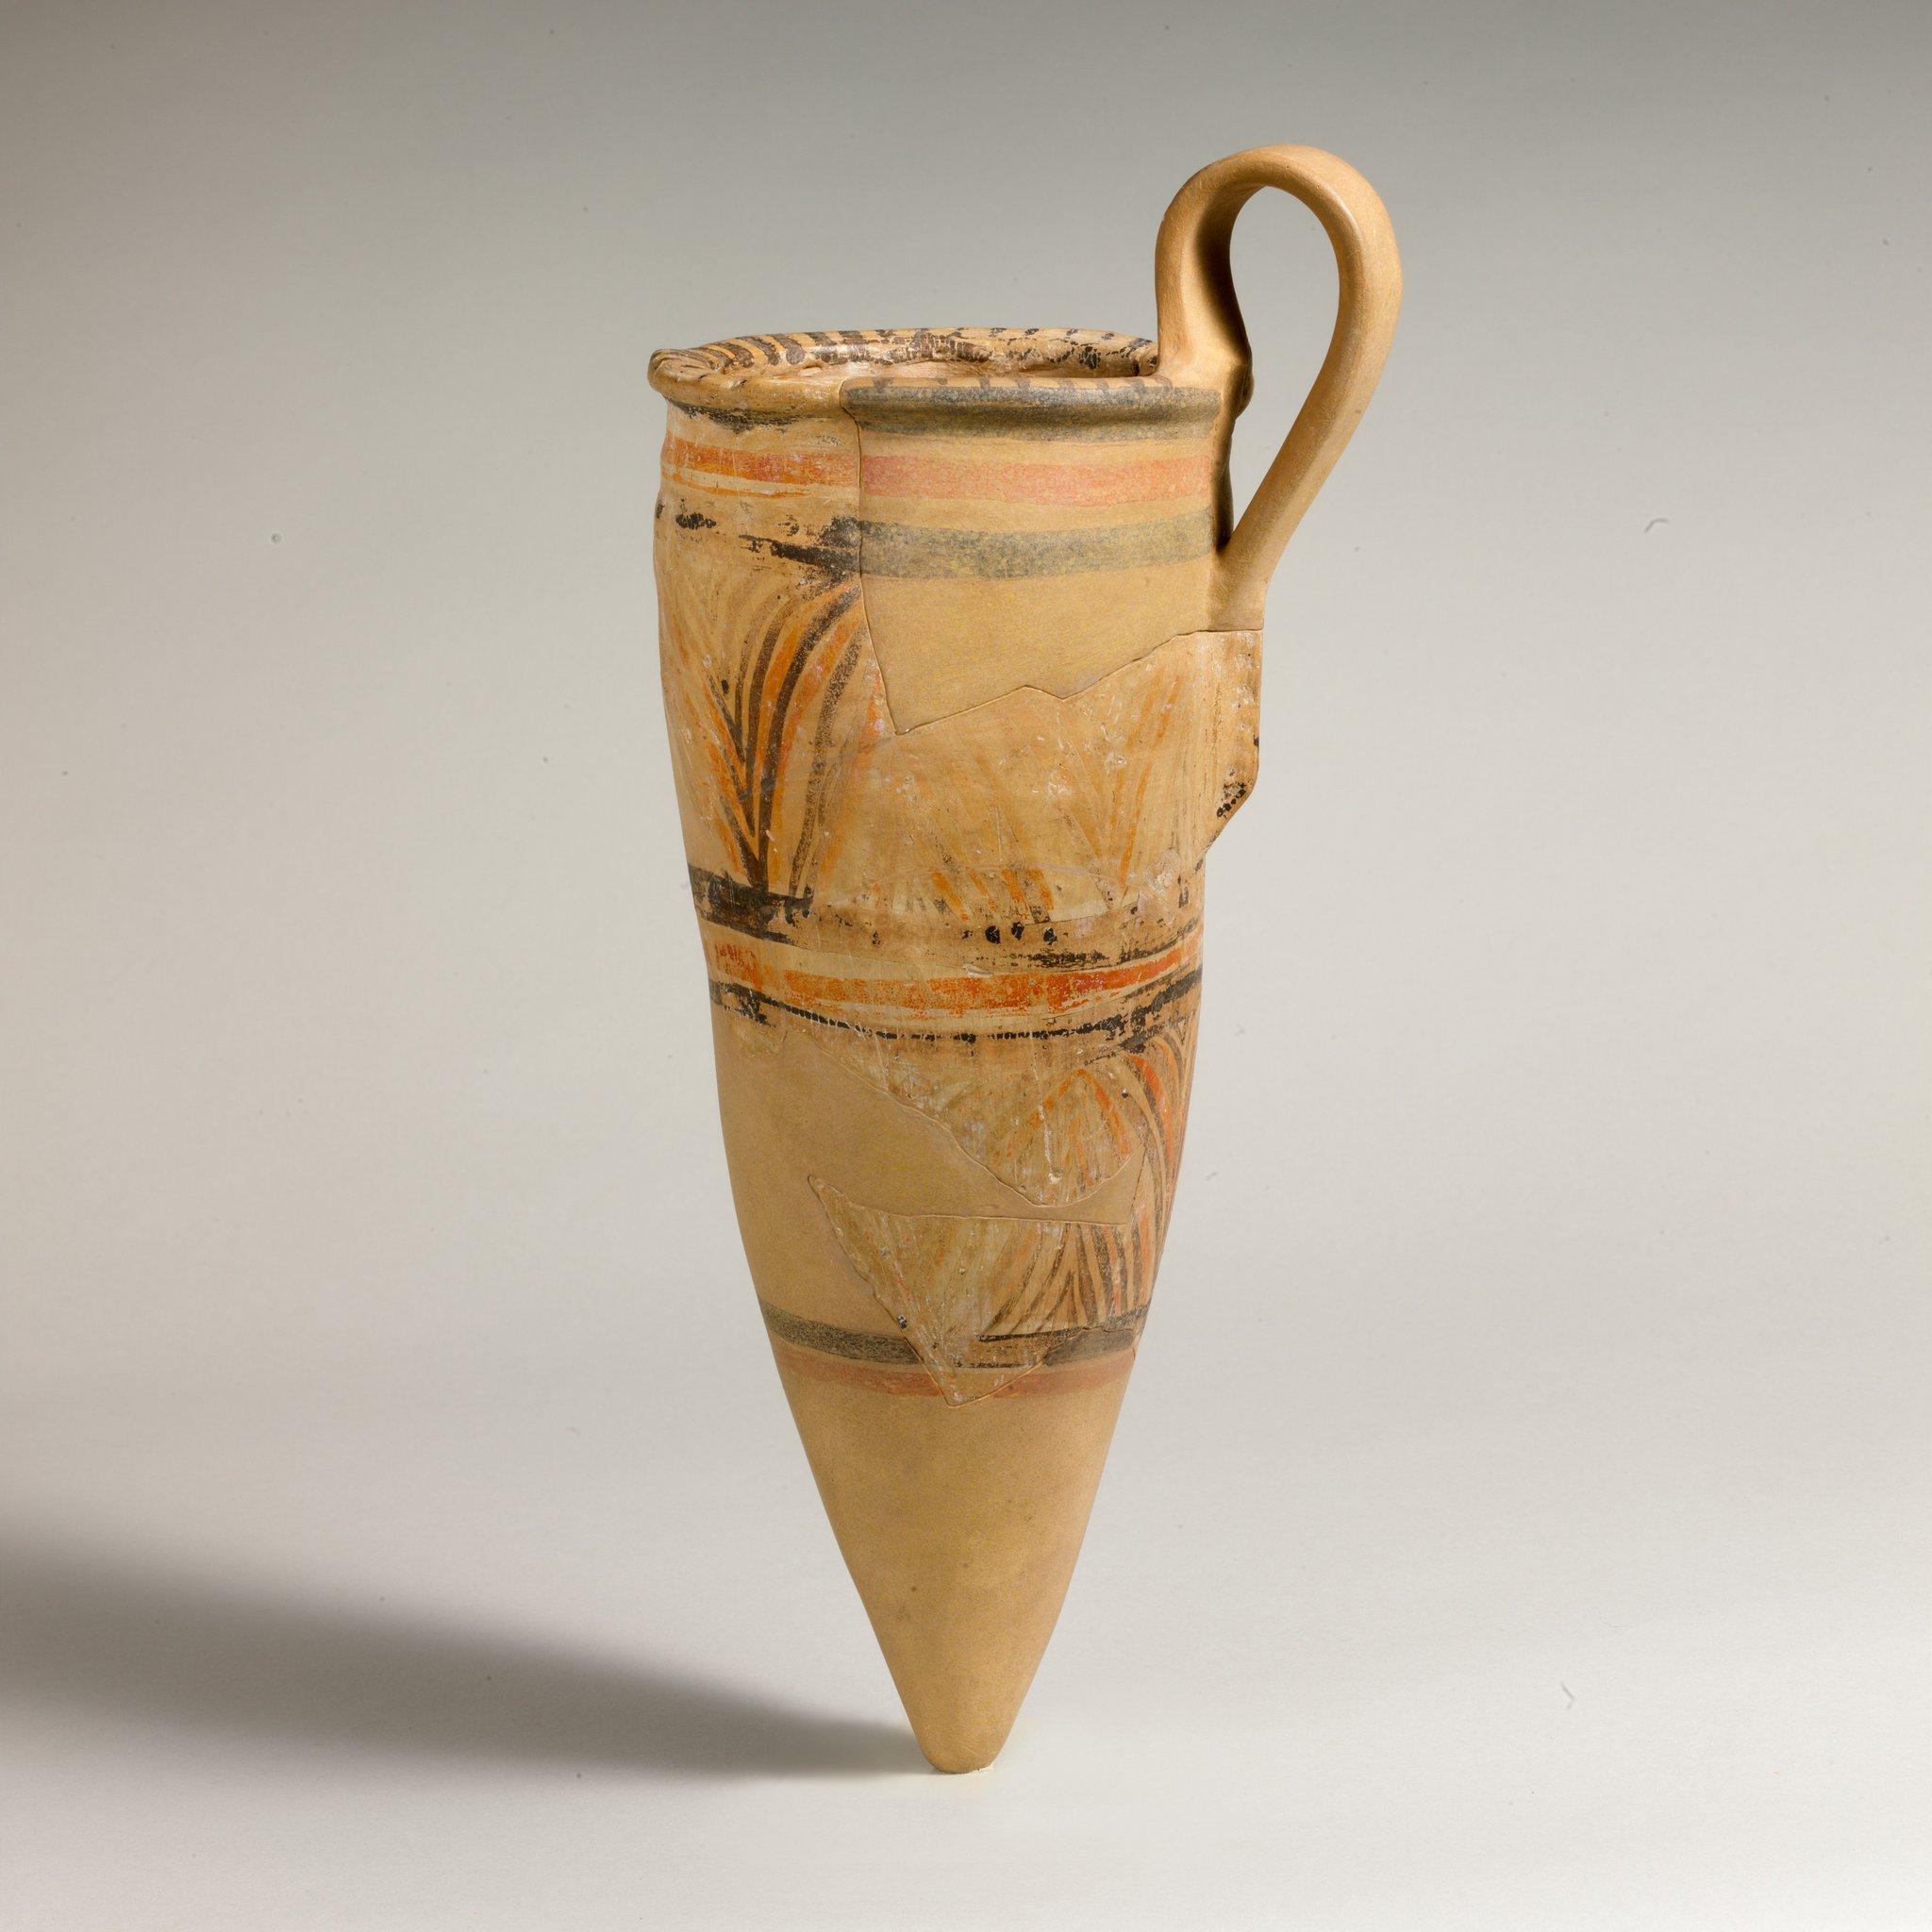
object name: filler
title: Terracotta conical rhyton (ritual vessel)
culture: minoan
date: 1600-1525 BCE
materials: terracotta